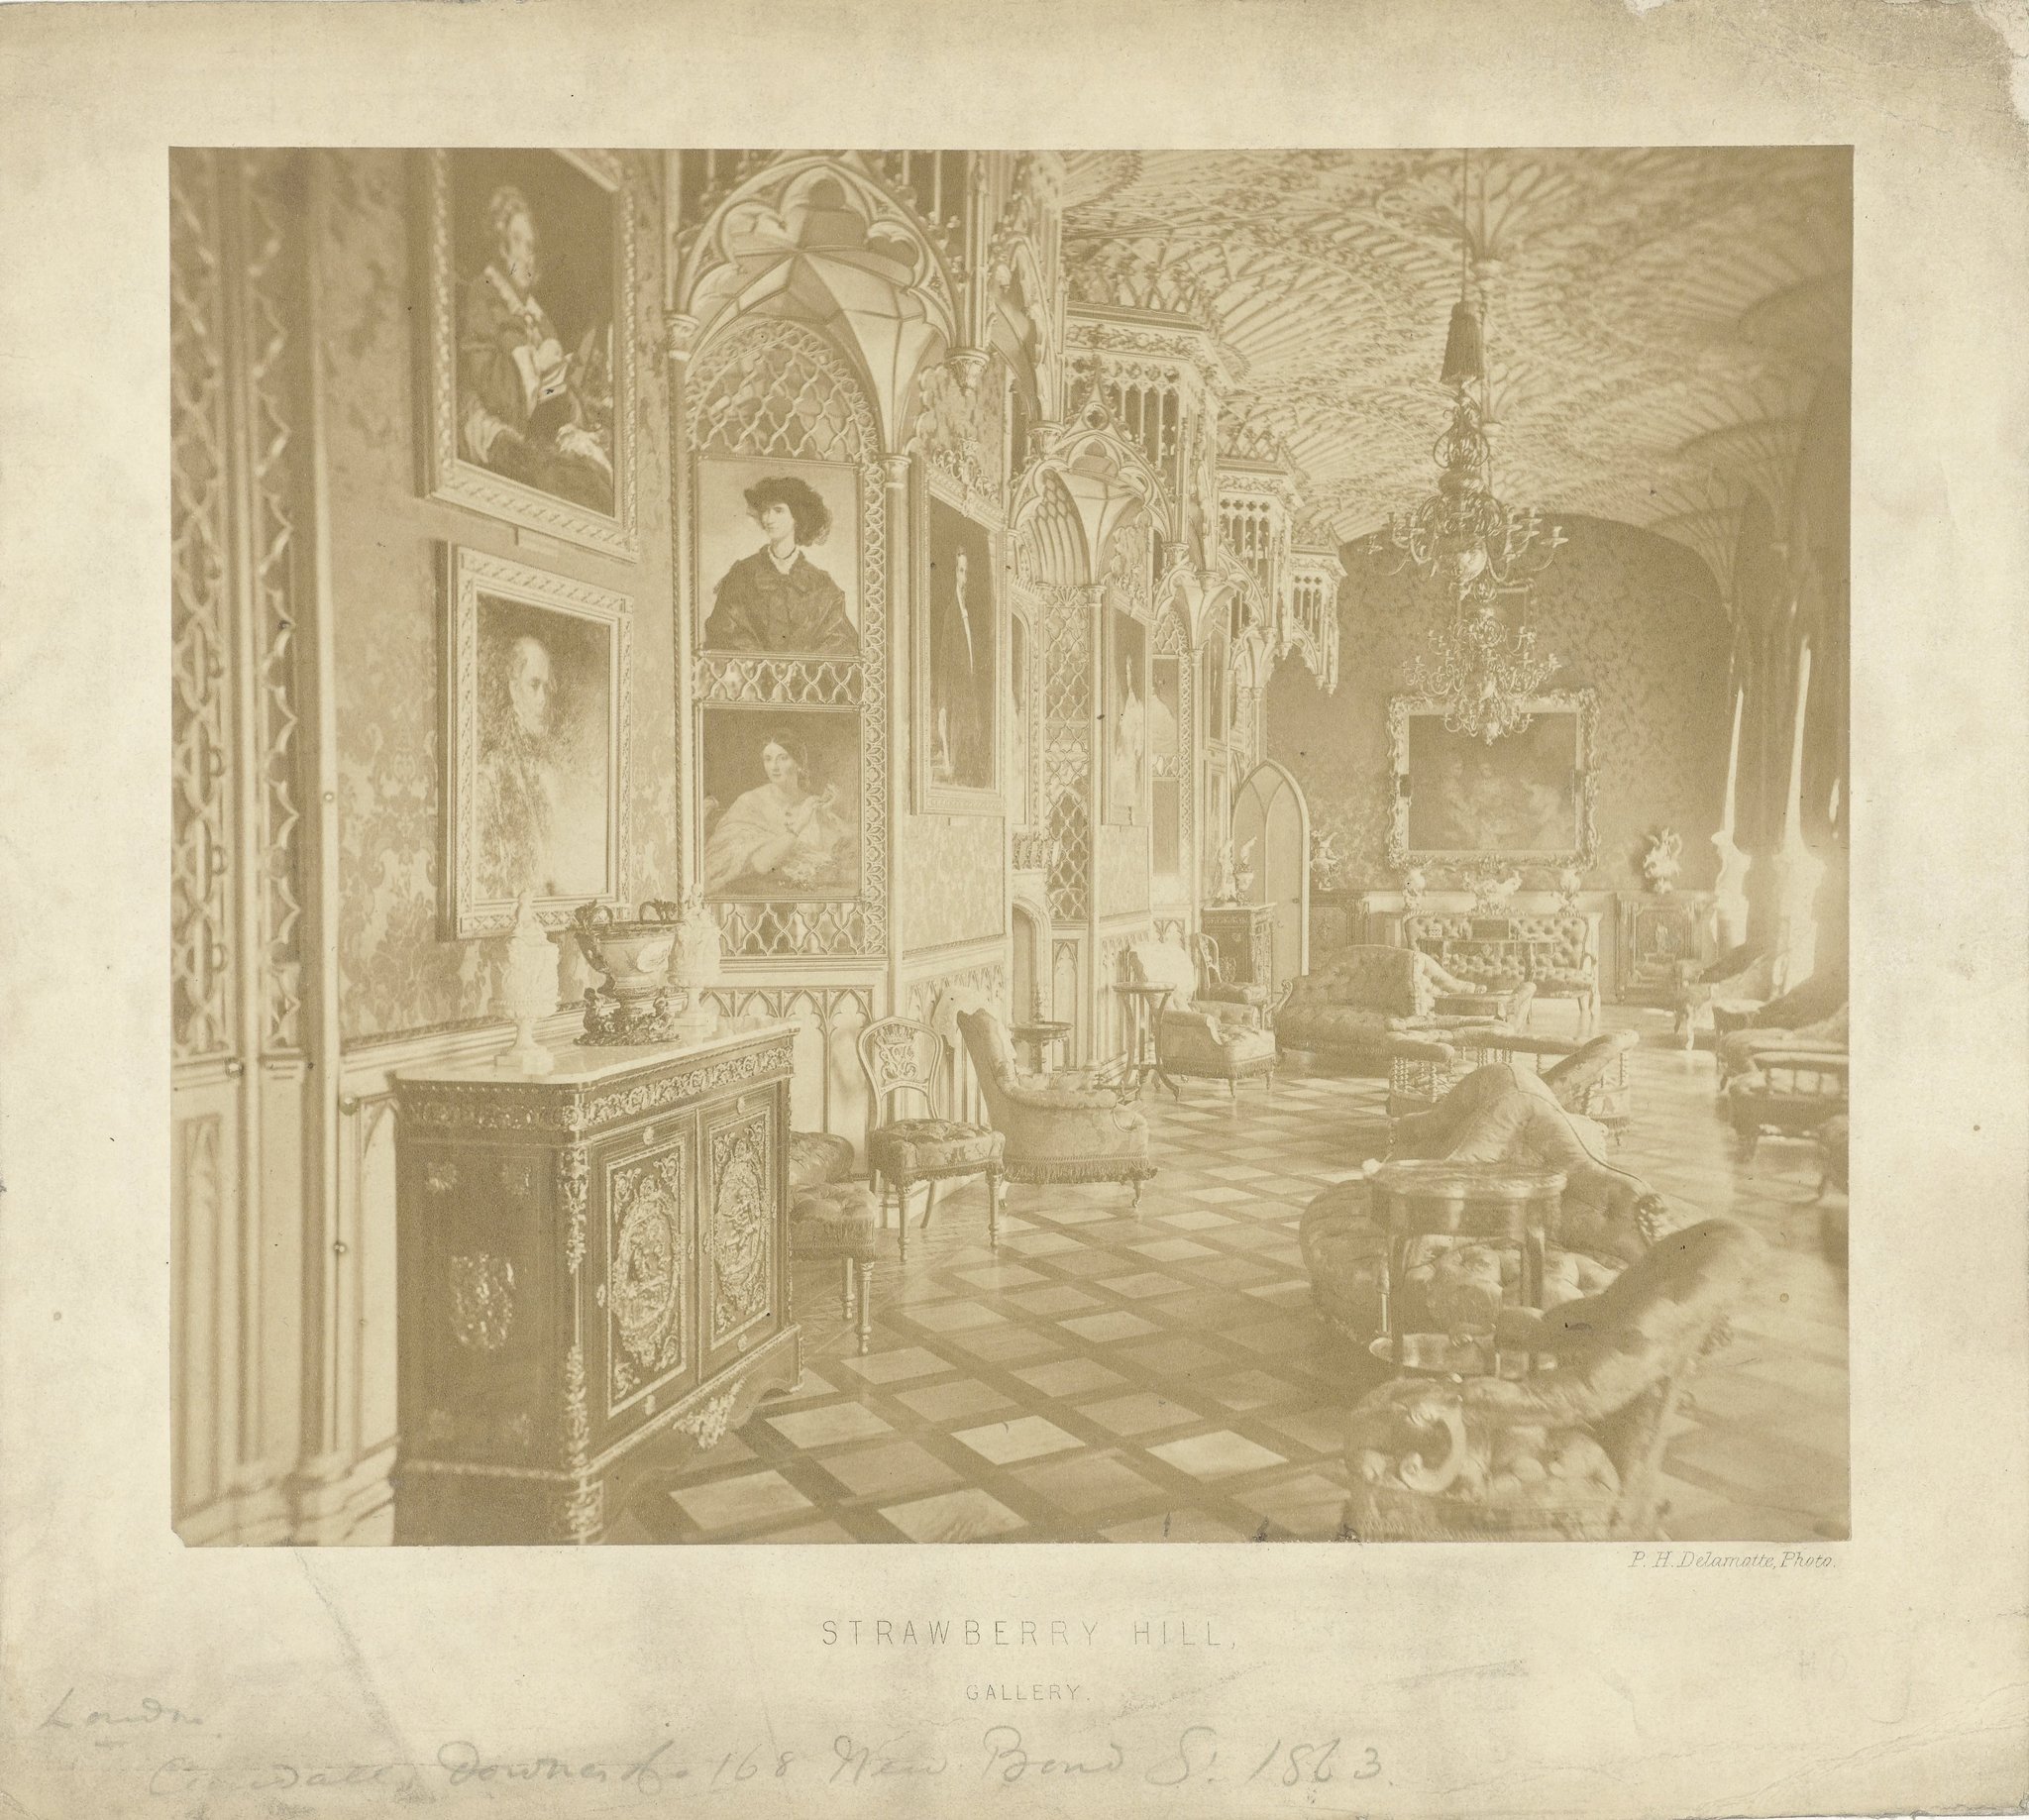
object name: photograph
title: Strawberry Hill Gallery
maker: philip henry delamotte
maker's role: draughtsman, painter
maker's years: 1821-1889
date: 1863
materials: cardboard, paper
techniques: albumen print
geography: london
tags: interior of the house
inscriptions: inscription: ‘London./ Cundall, Downes Co 168 New Bond S. 1863.’, name: ‘P.H. Delamotte, Photo.’